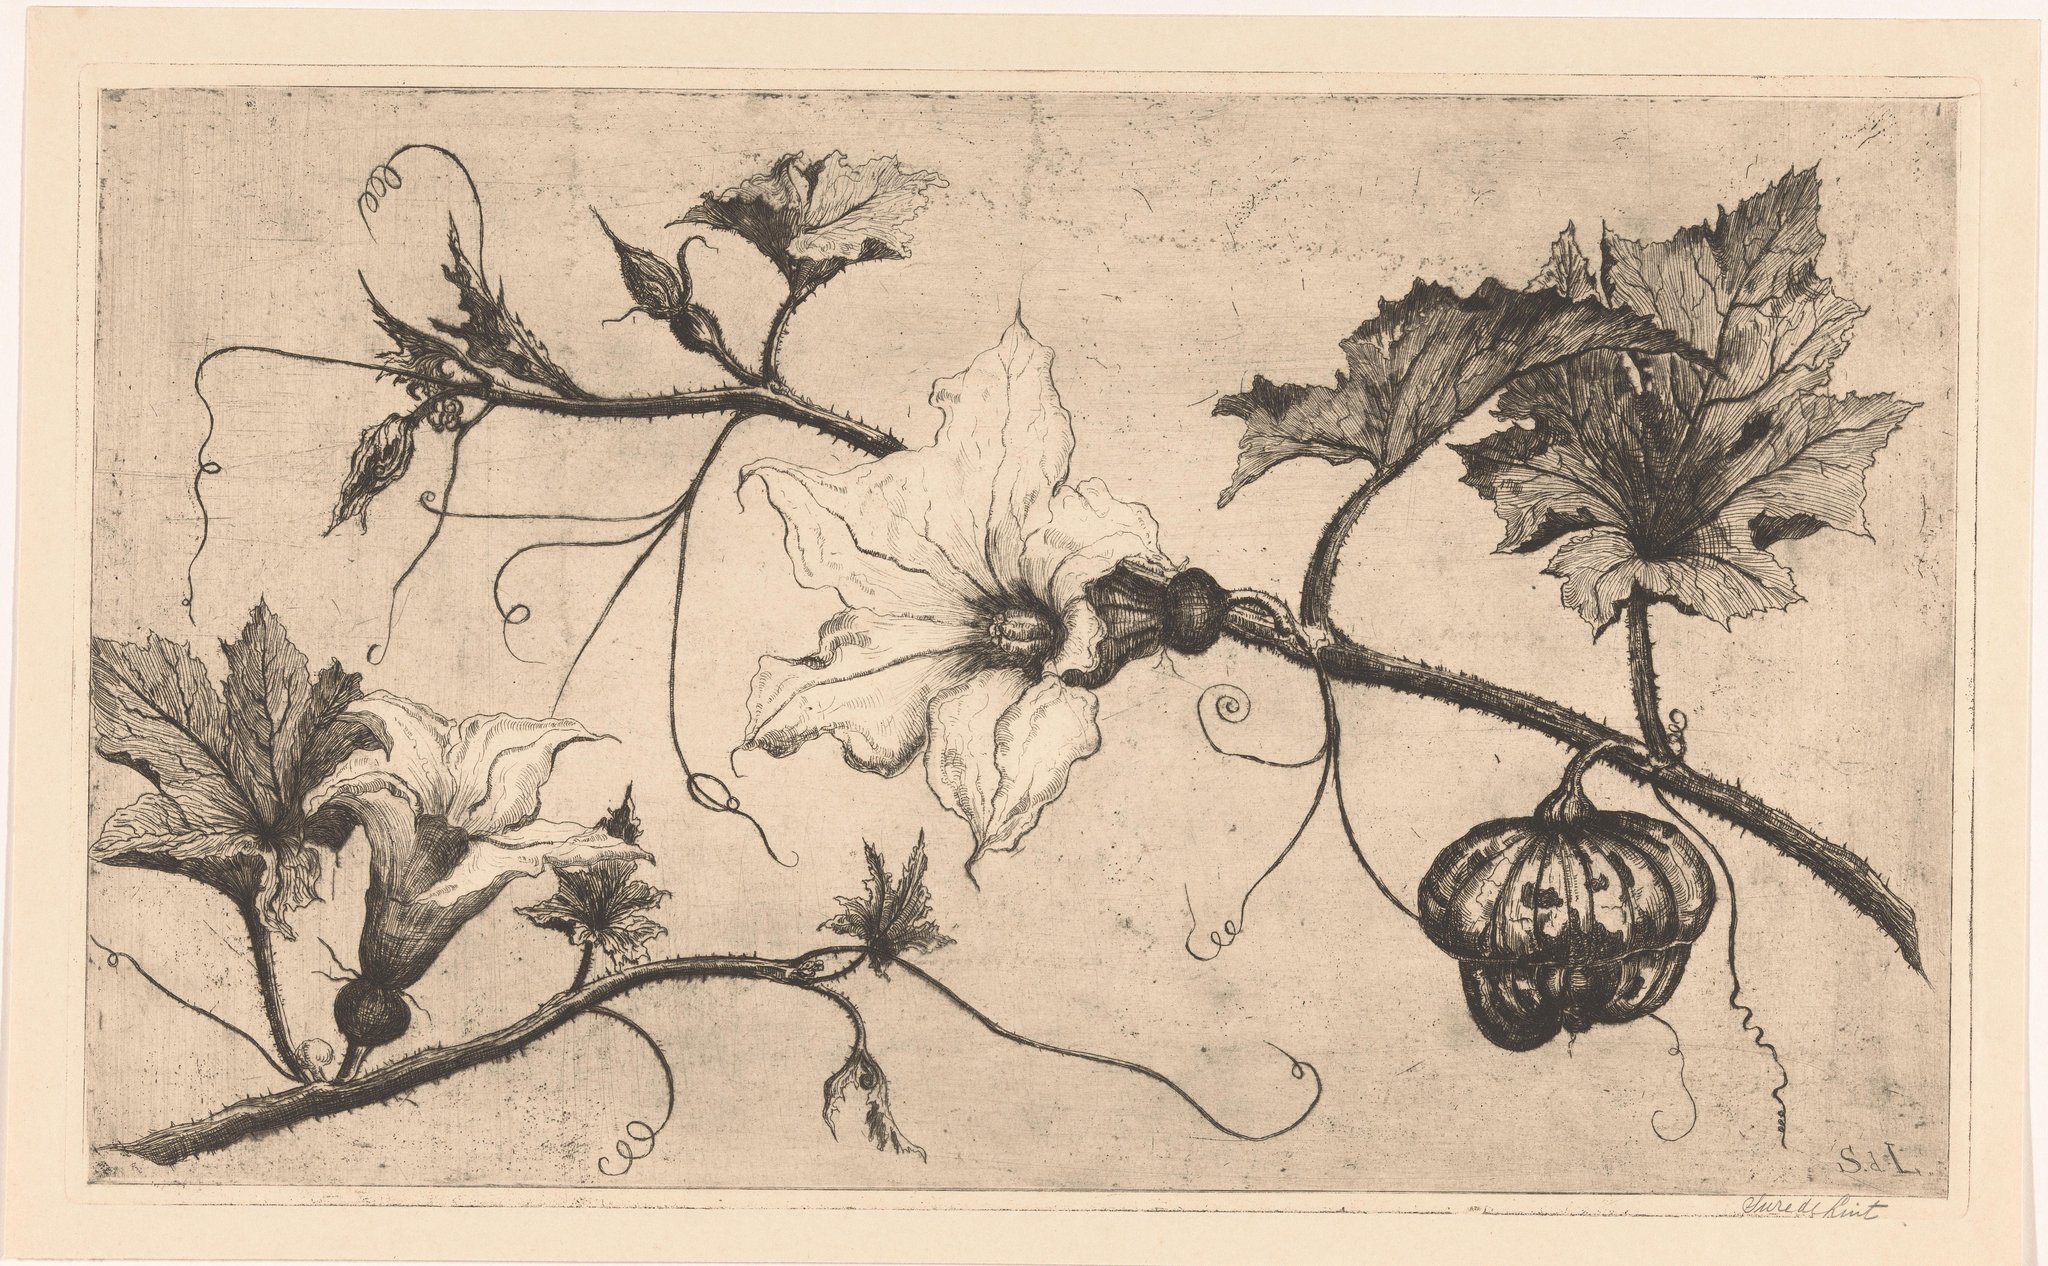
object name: print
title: Sierpompoenen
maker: suze de lint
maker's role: print maker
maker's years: 1878-1953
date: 1888-1931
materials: paper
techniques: etching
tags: plants and herbs: pumpkin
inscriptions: collector's mark: Lugt 2228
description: Twee takken met pompoenbloemen en rechts een pompoen.